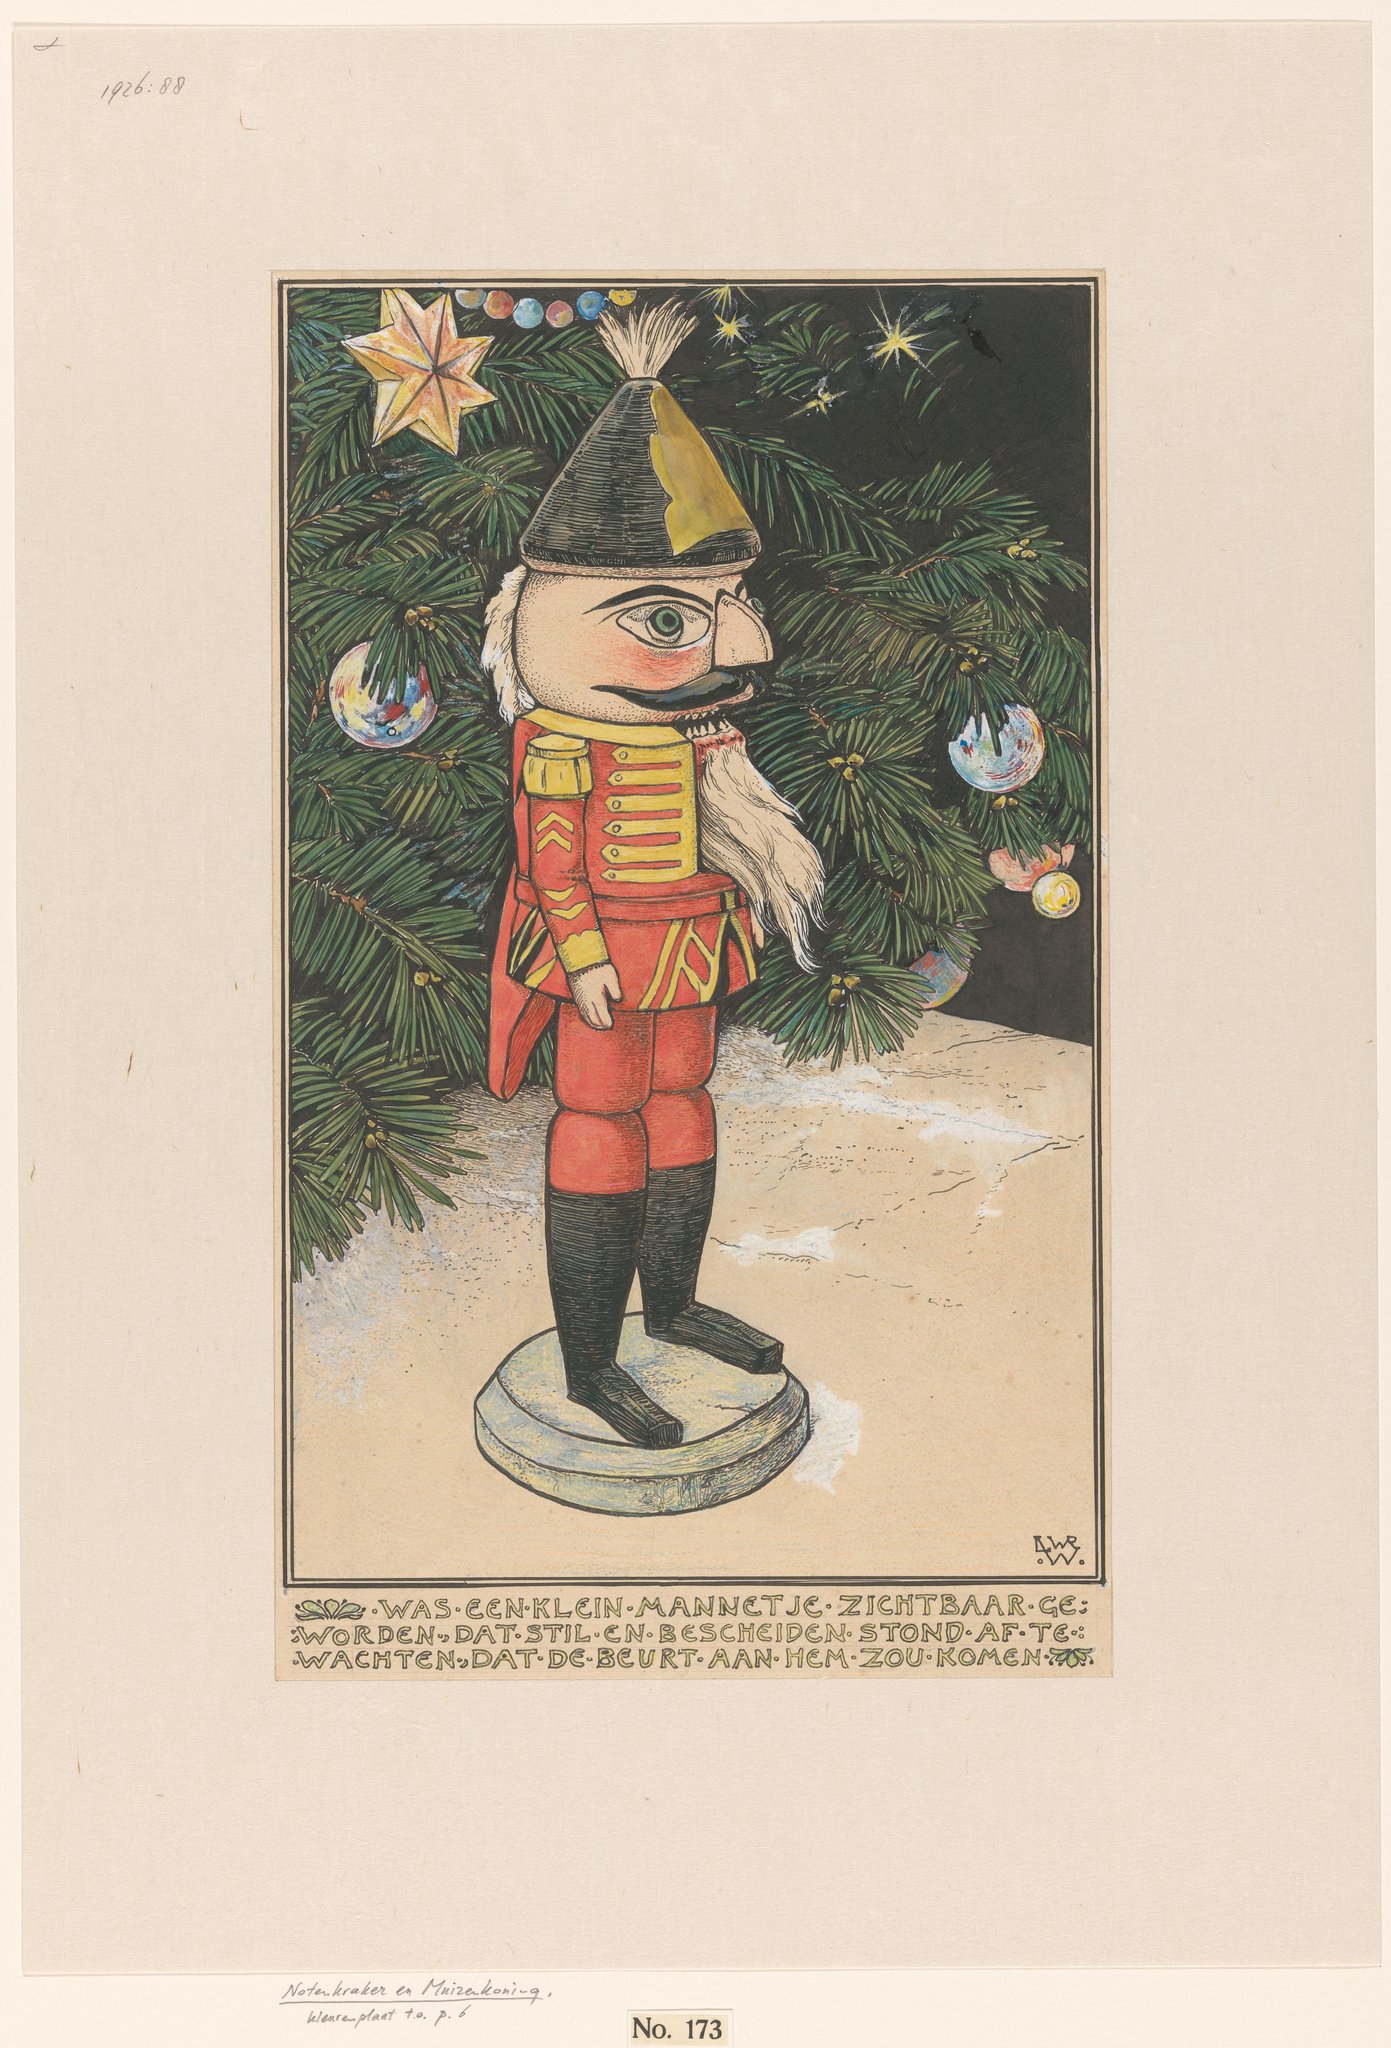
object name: boekillustratie ontwerp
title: Notenkraker in een huzarenmantel bij een kerstboom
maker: willem wenckebach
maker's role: designer, draughtsman, painter, print maker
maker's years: 1860-1937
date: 1898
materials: chalk, paint, ink, paper, watercolor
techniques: brush, pen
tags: christmas tree, (playing with) dolls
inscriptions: number: ‘no. 173’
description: De Notenkraker, in de figuur van een bebaard miniatuurmannetje, draagt het kostuum van een huzaar bestaande uit een mantel, laarzen en muts met pluim. Achter hem is een versierde kerstboom te zien.